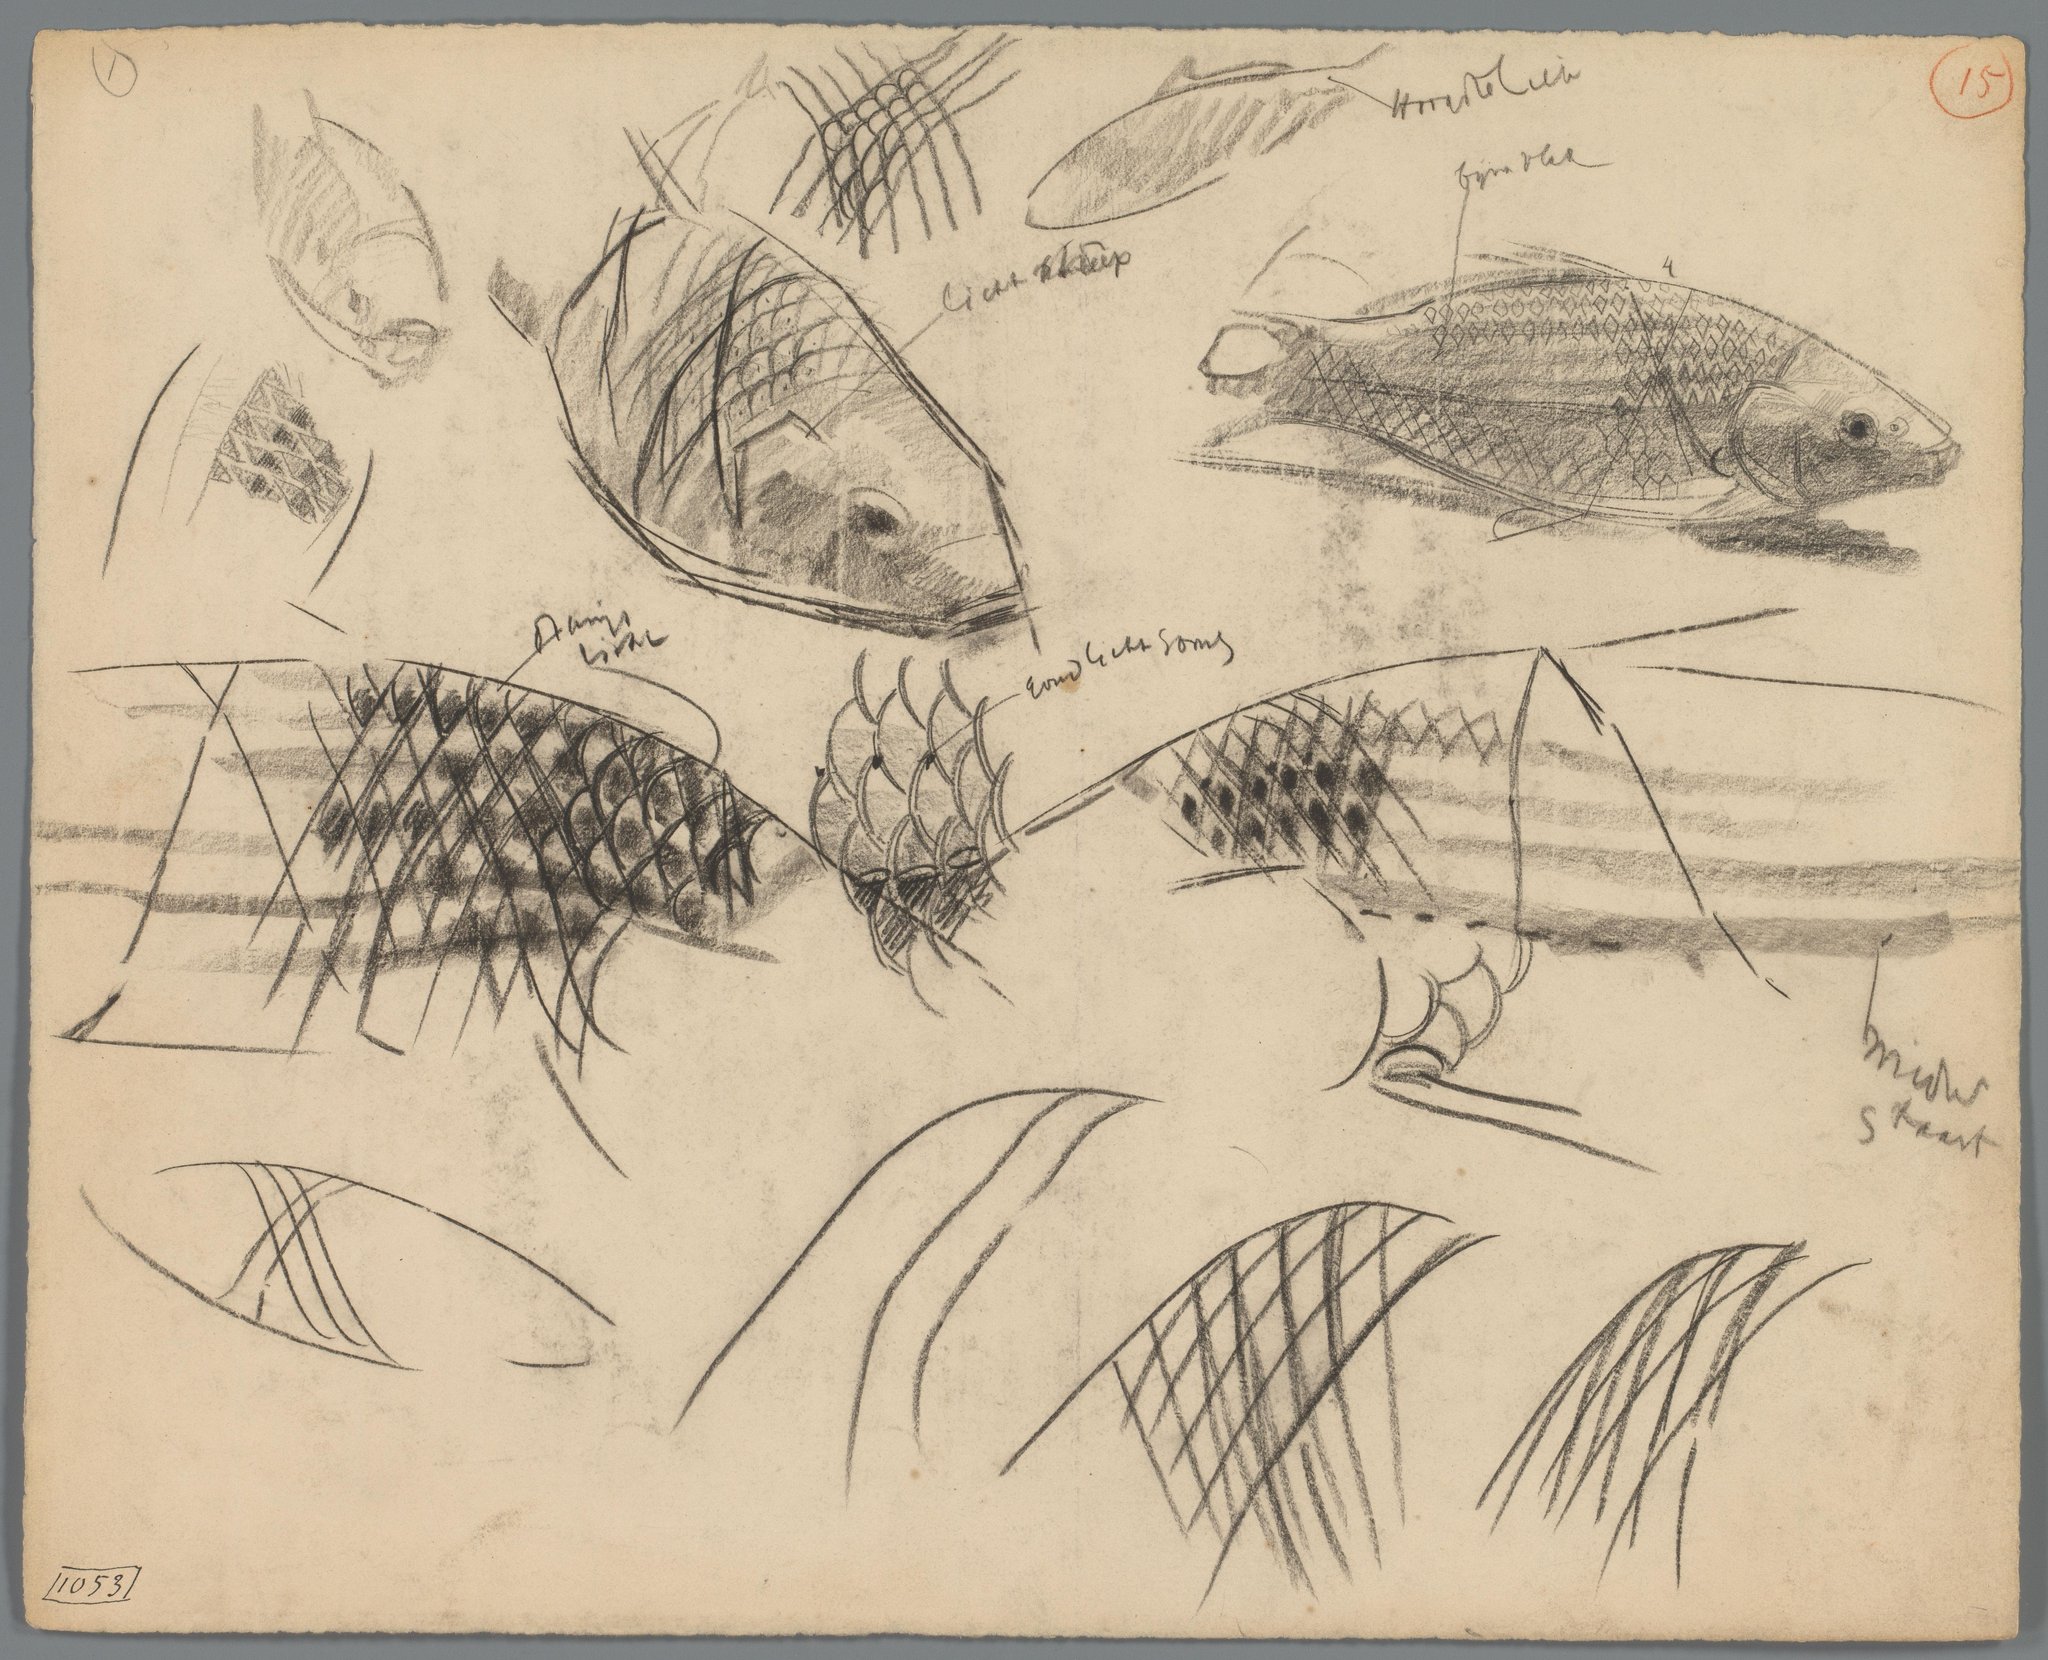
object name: drawing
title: Studies van de schubben van karpers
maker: gerrit willem dijsselhof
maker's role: designer, draughtsman, print maker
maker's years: 1866-1924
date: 1876-1924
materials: chalk, paper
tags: bony fishes: carp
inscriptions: number: ‘1053’